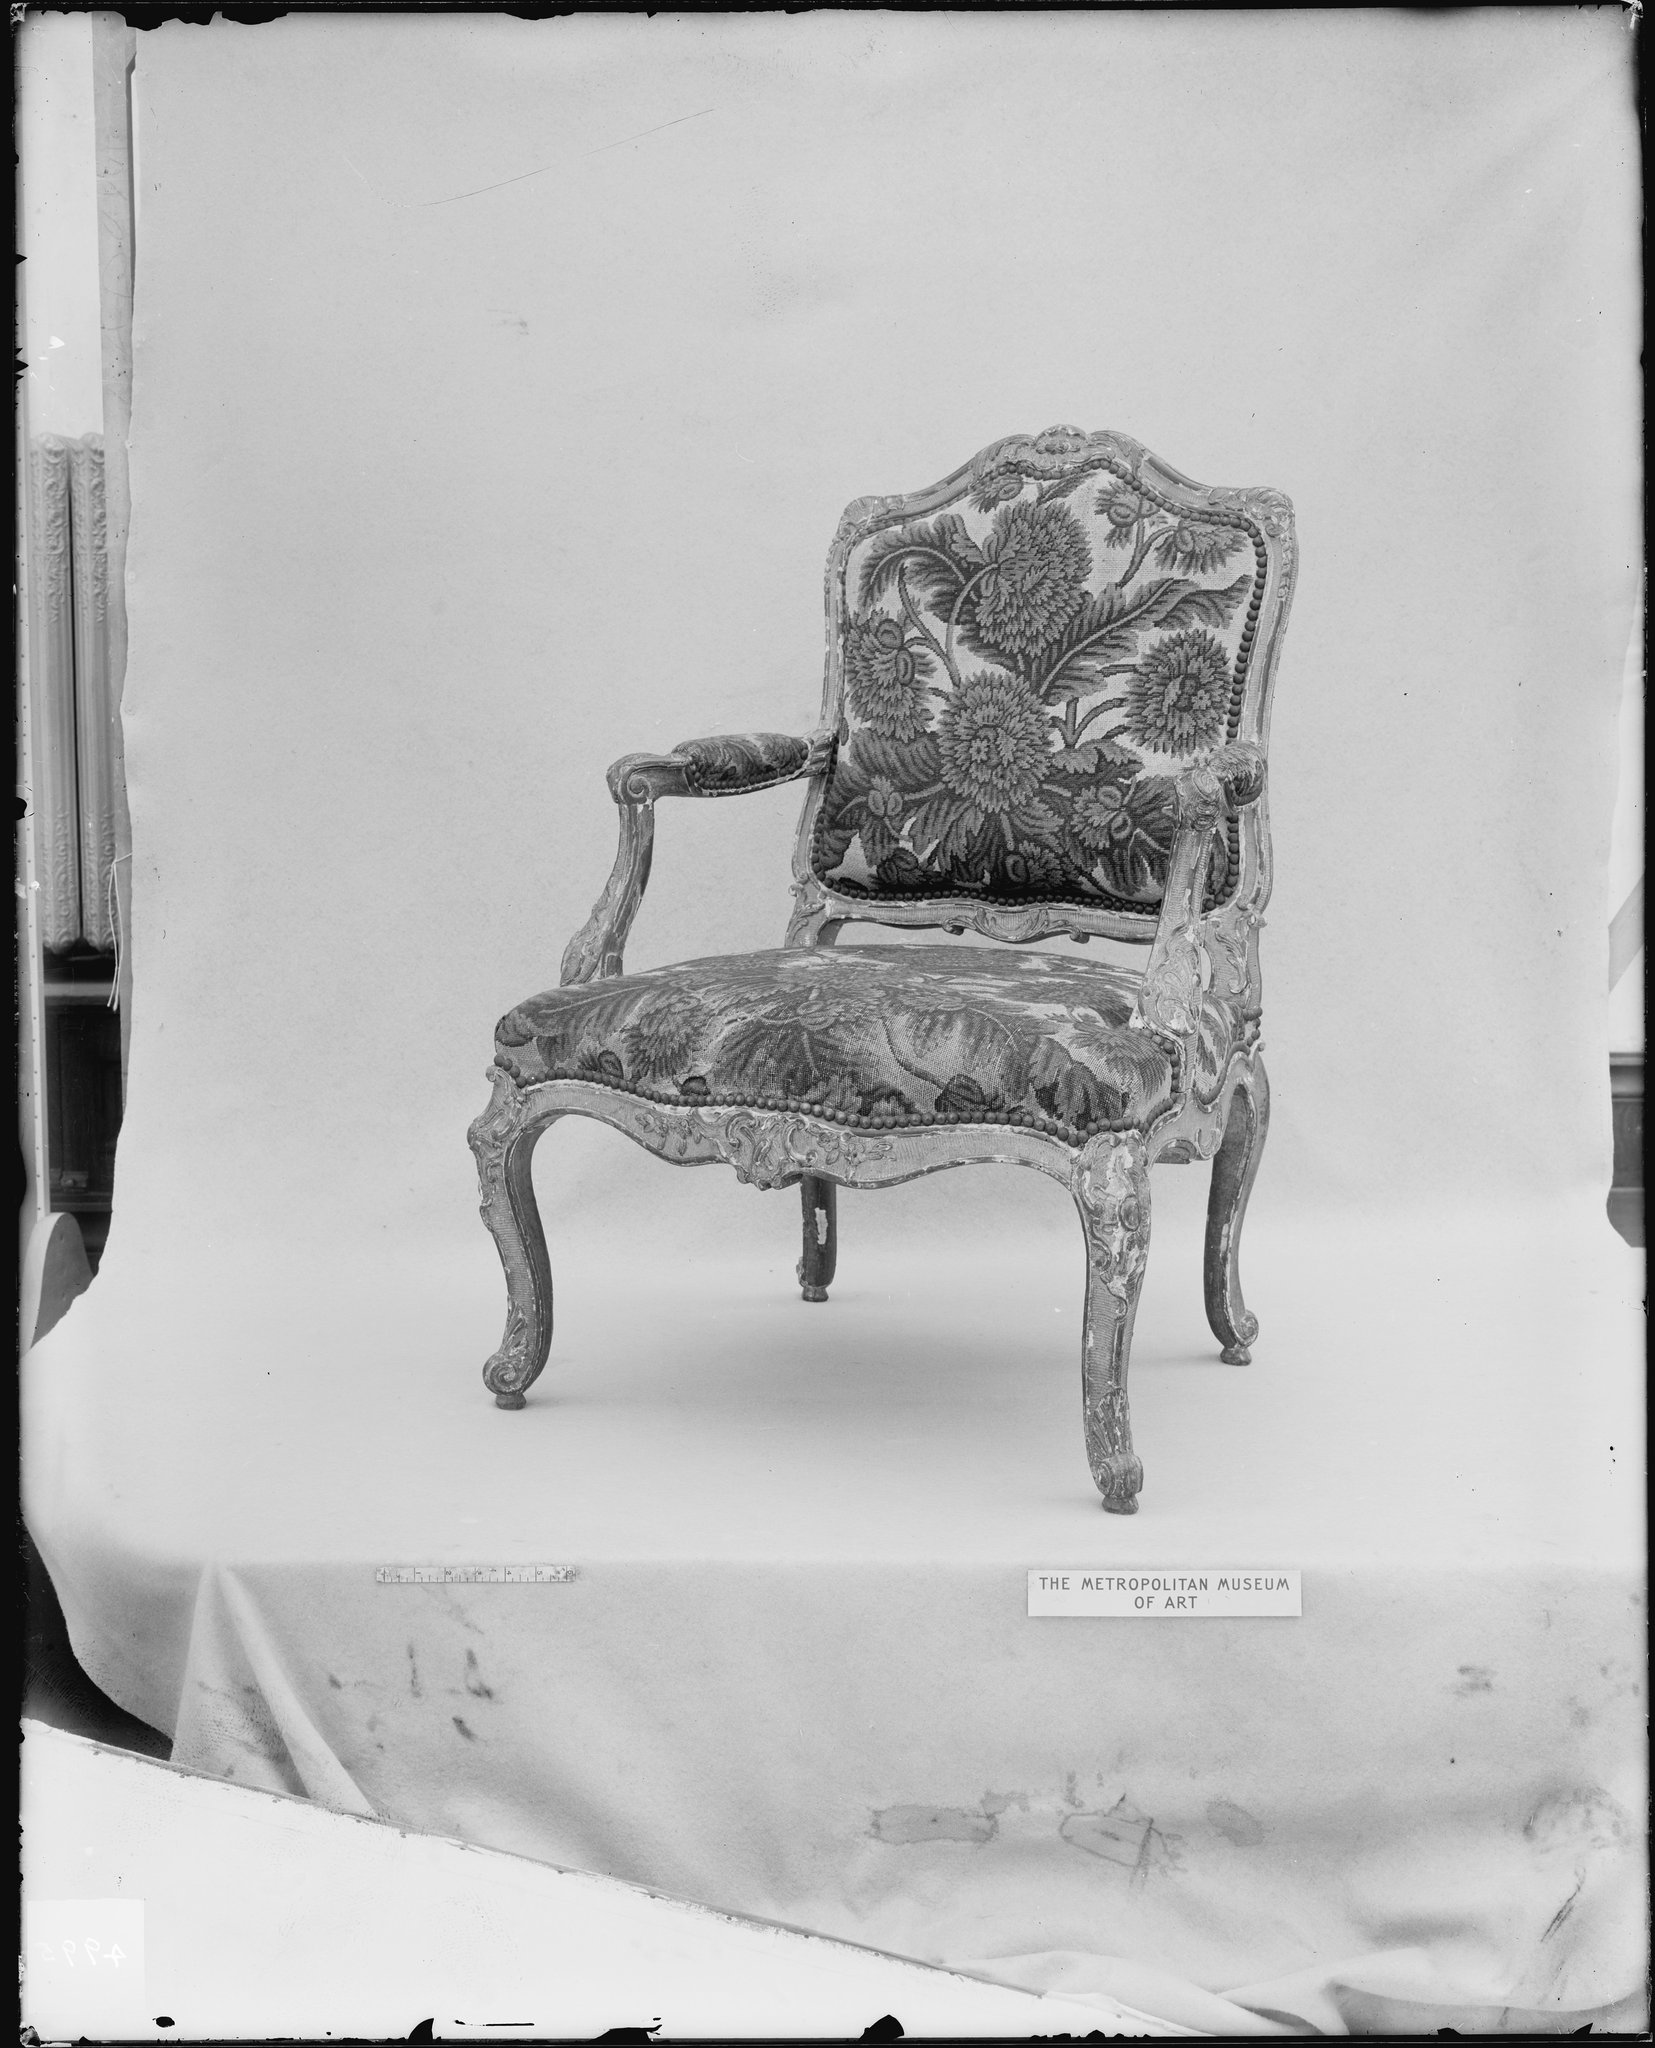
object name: armchair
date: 1701-1800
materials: wood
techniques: carving, gilding